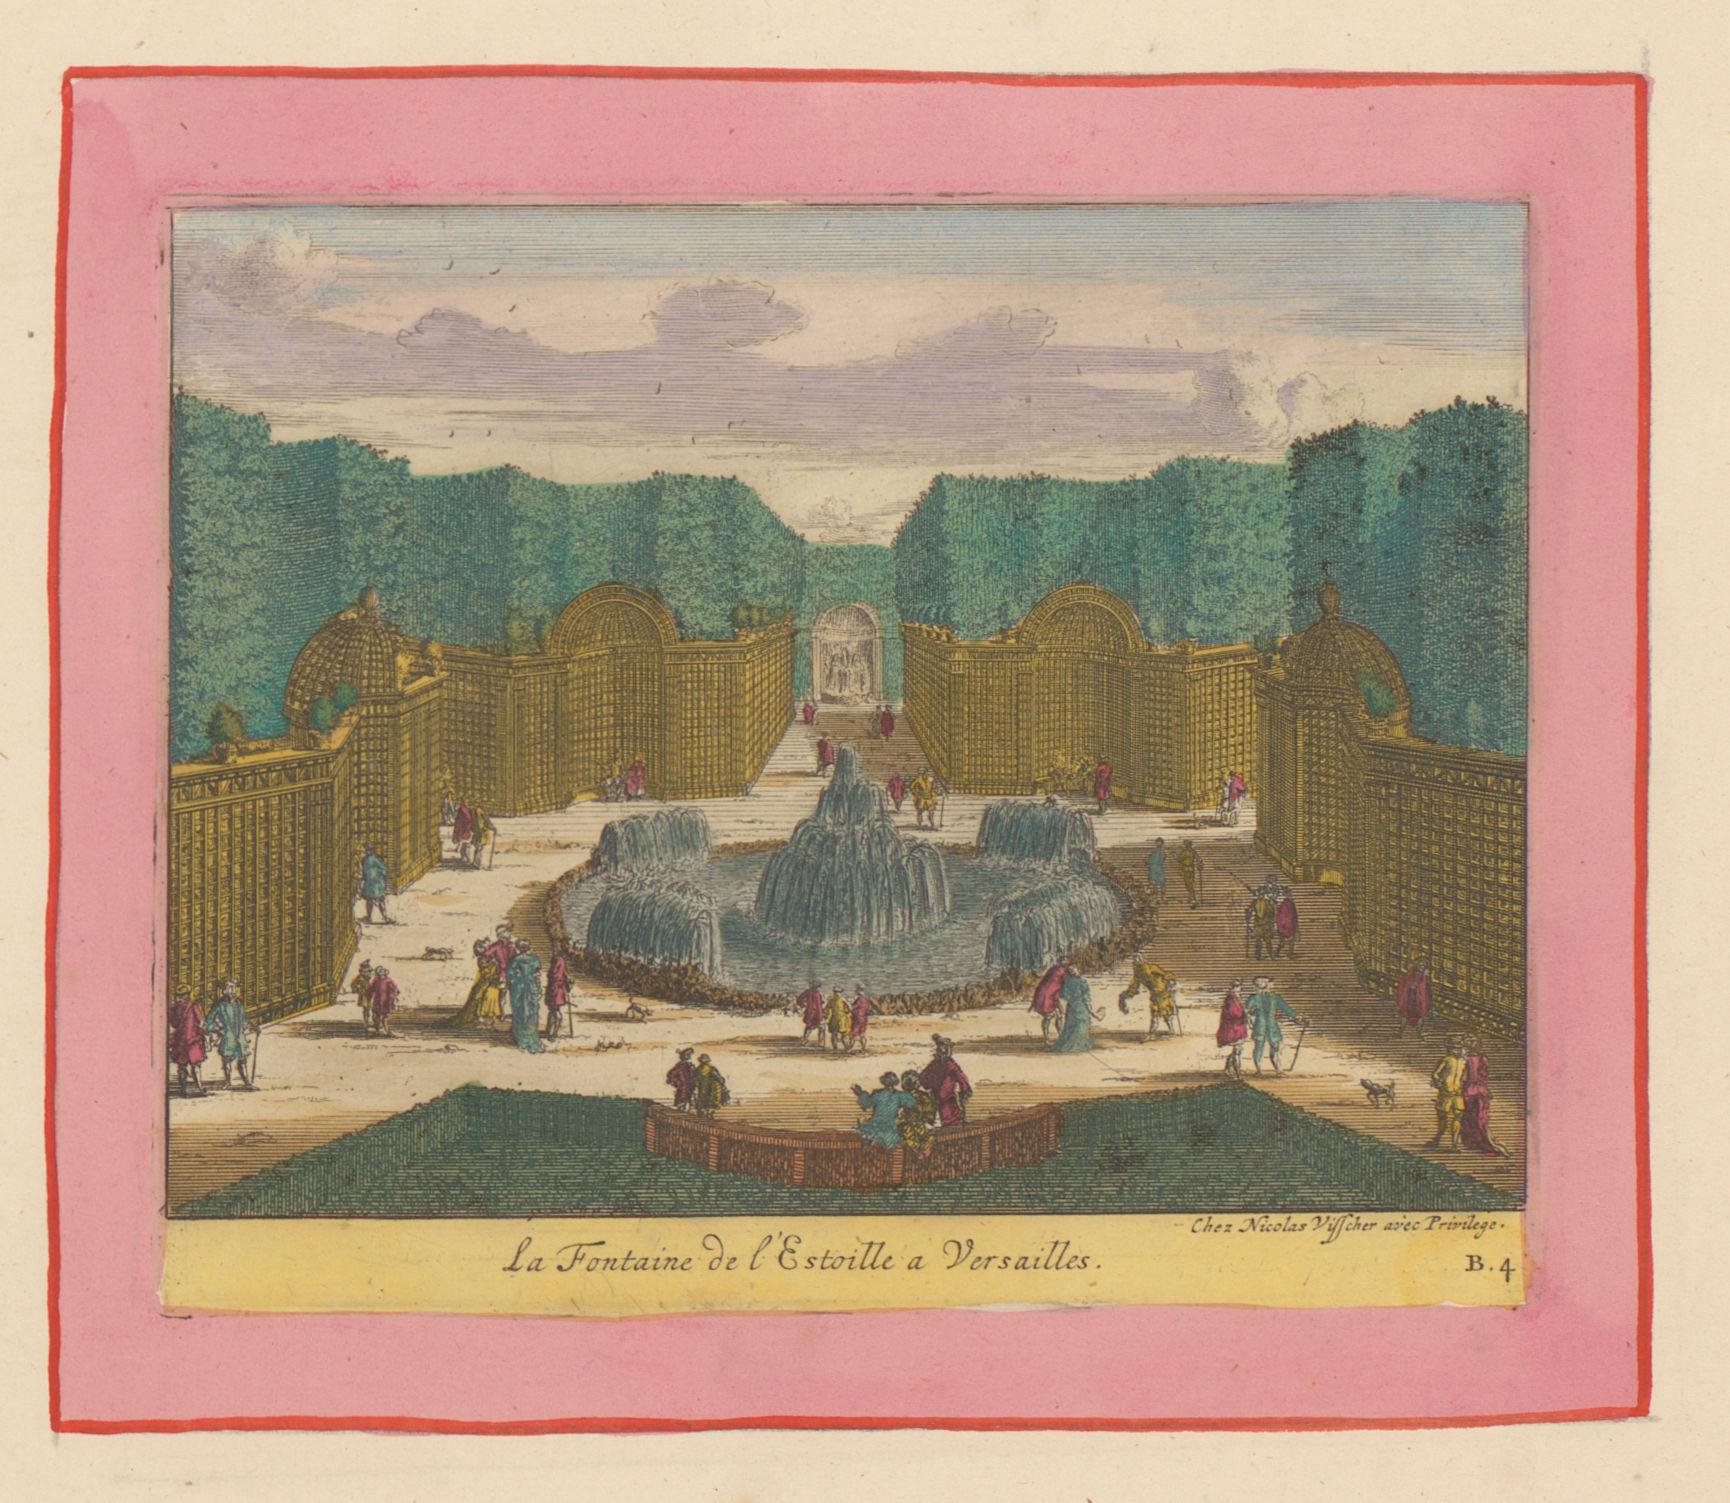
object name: print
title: Veues de Versailles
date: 1686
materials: paper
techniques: etching, hand coloring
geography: amsterdam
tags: garden fountain, french or architectonic garden; formal garden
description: De prent maakt deel uit van een serie bestaande uit 87 genummerde prenten (volgens Hollstein). De serie is opgedeeld in de delen A t/m F.